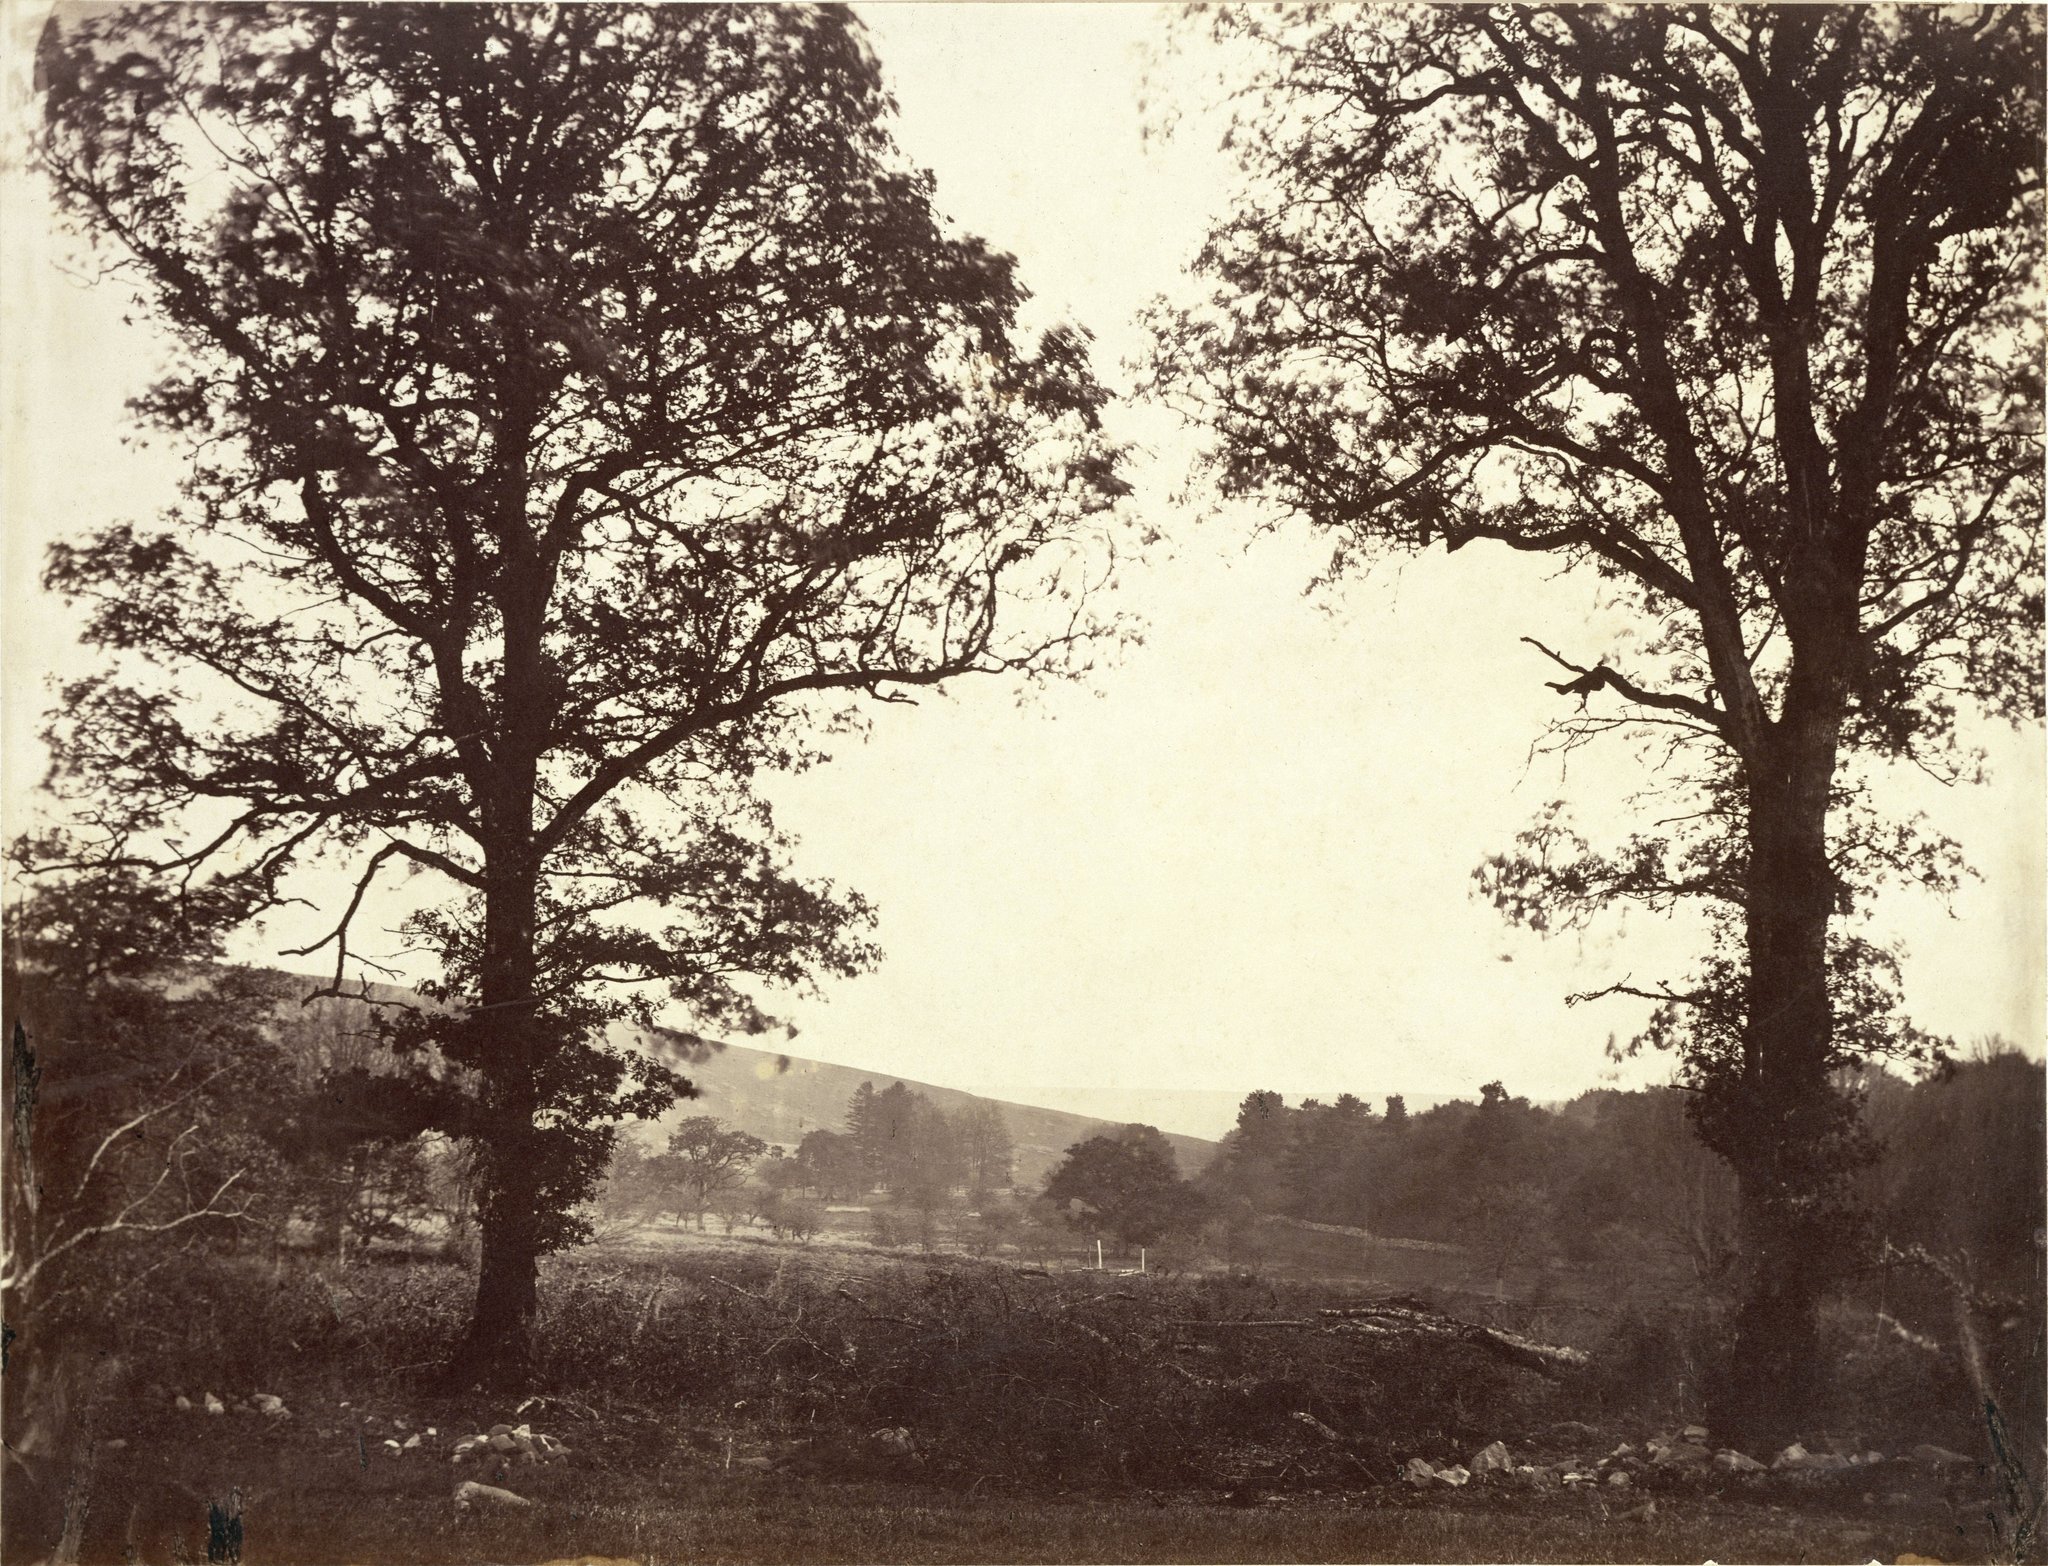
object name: photograph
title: Landscape with Elms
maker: william 2nd earl of craven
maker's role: fotograaf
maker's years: 1809-1866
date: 1855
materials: cardboard, photographic support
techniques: albumen print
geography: great britain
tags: low hill country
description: Craven found most of his subjects close to home, namely on his own estate, Ashdown. He was one of the many well-to-do amateur photographers who held their own with professional colleagues in the 1850s. In addition to his family, Craven mostly photographed the trees on his estate. Given his background he must have been familiar with drawing and painting.